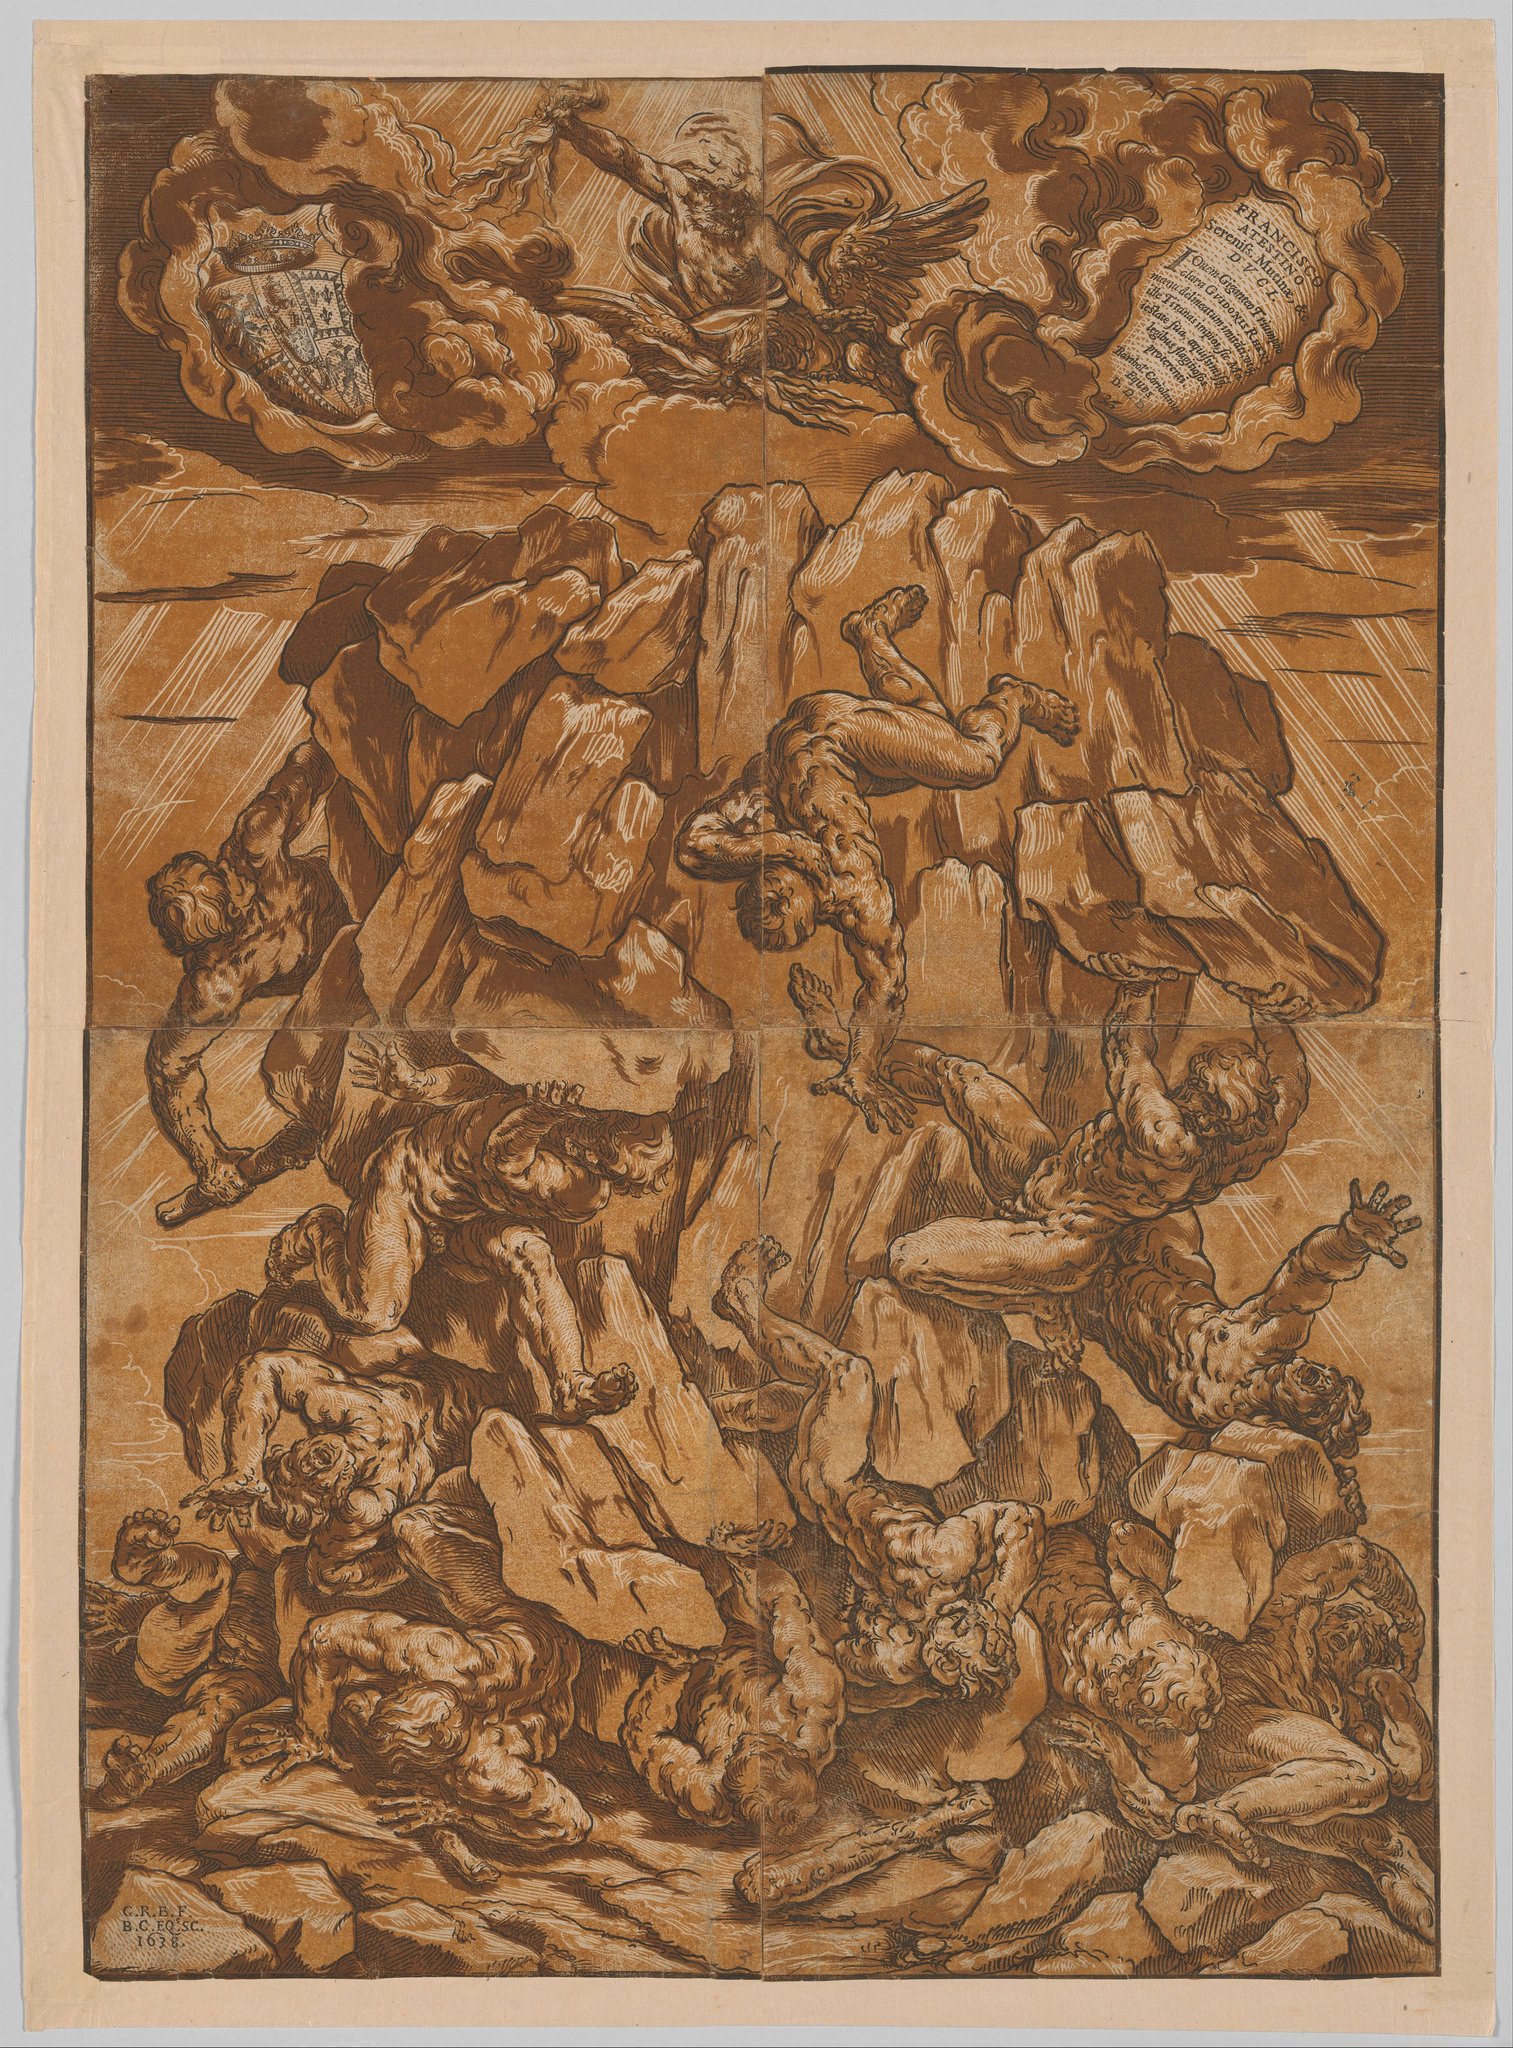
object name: print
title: Fall of the Giants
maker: bartolomeo coriolano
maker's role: artist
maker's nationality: italian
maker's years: 1599-1676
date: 1638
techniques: woodcut, printing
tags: male nudes